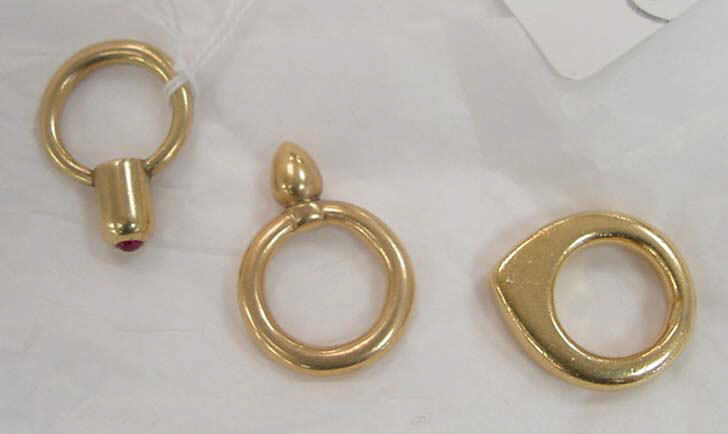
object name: jewelry set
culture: indian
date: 1801-1900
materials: gold, gemstone